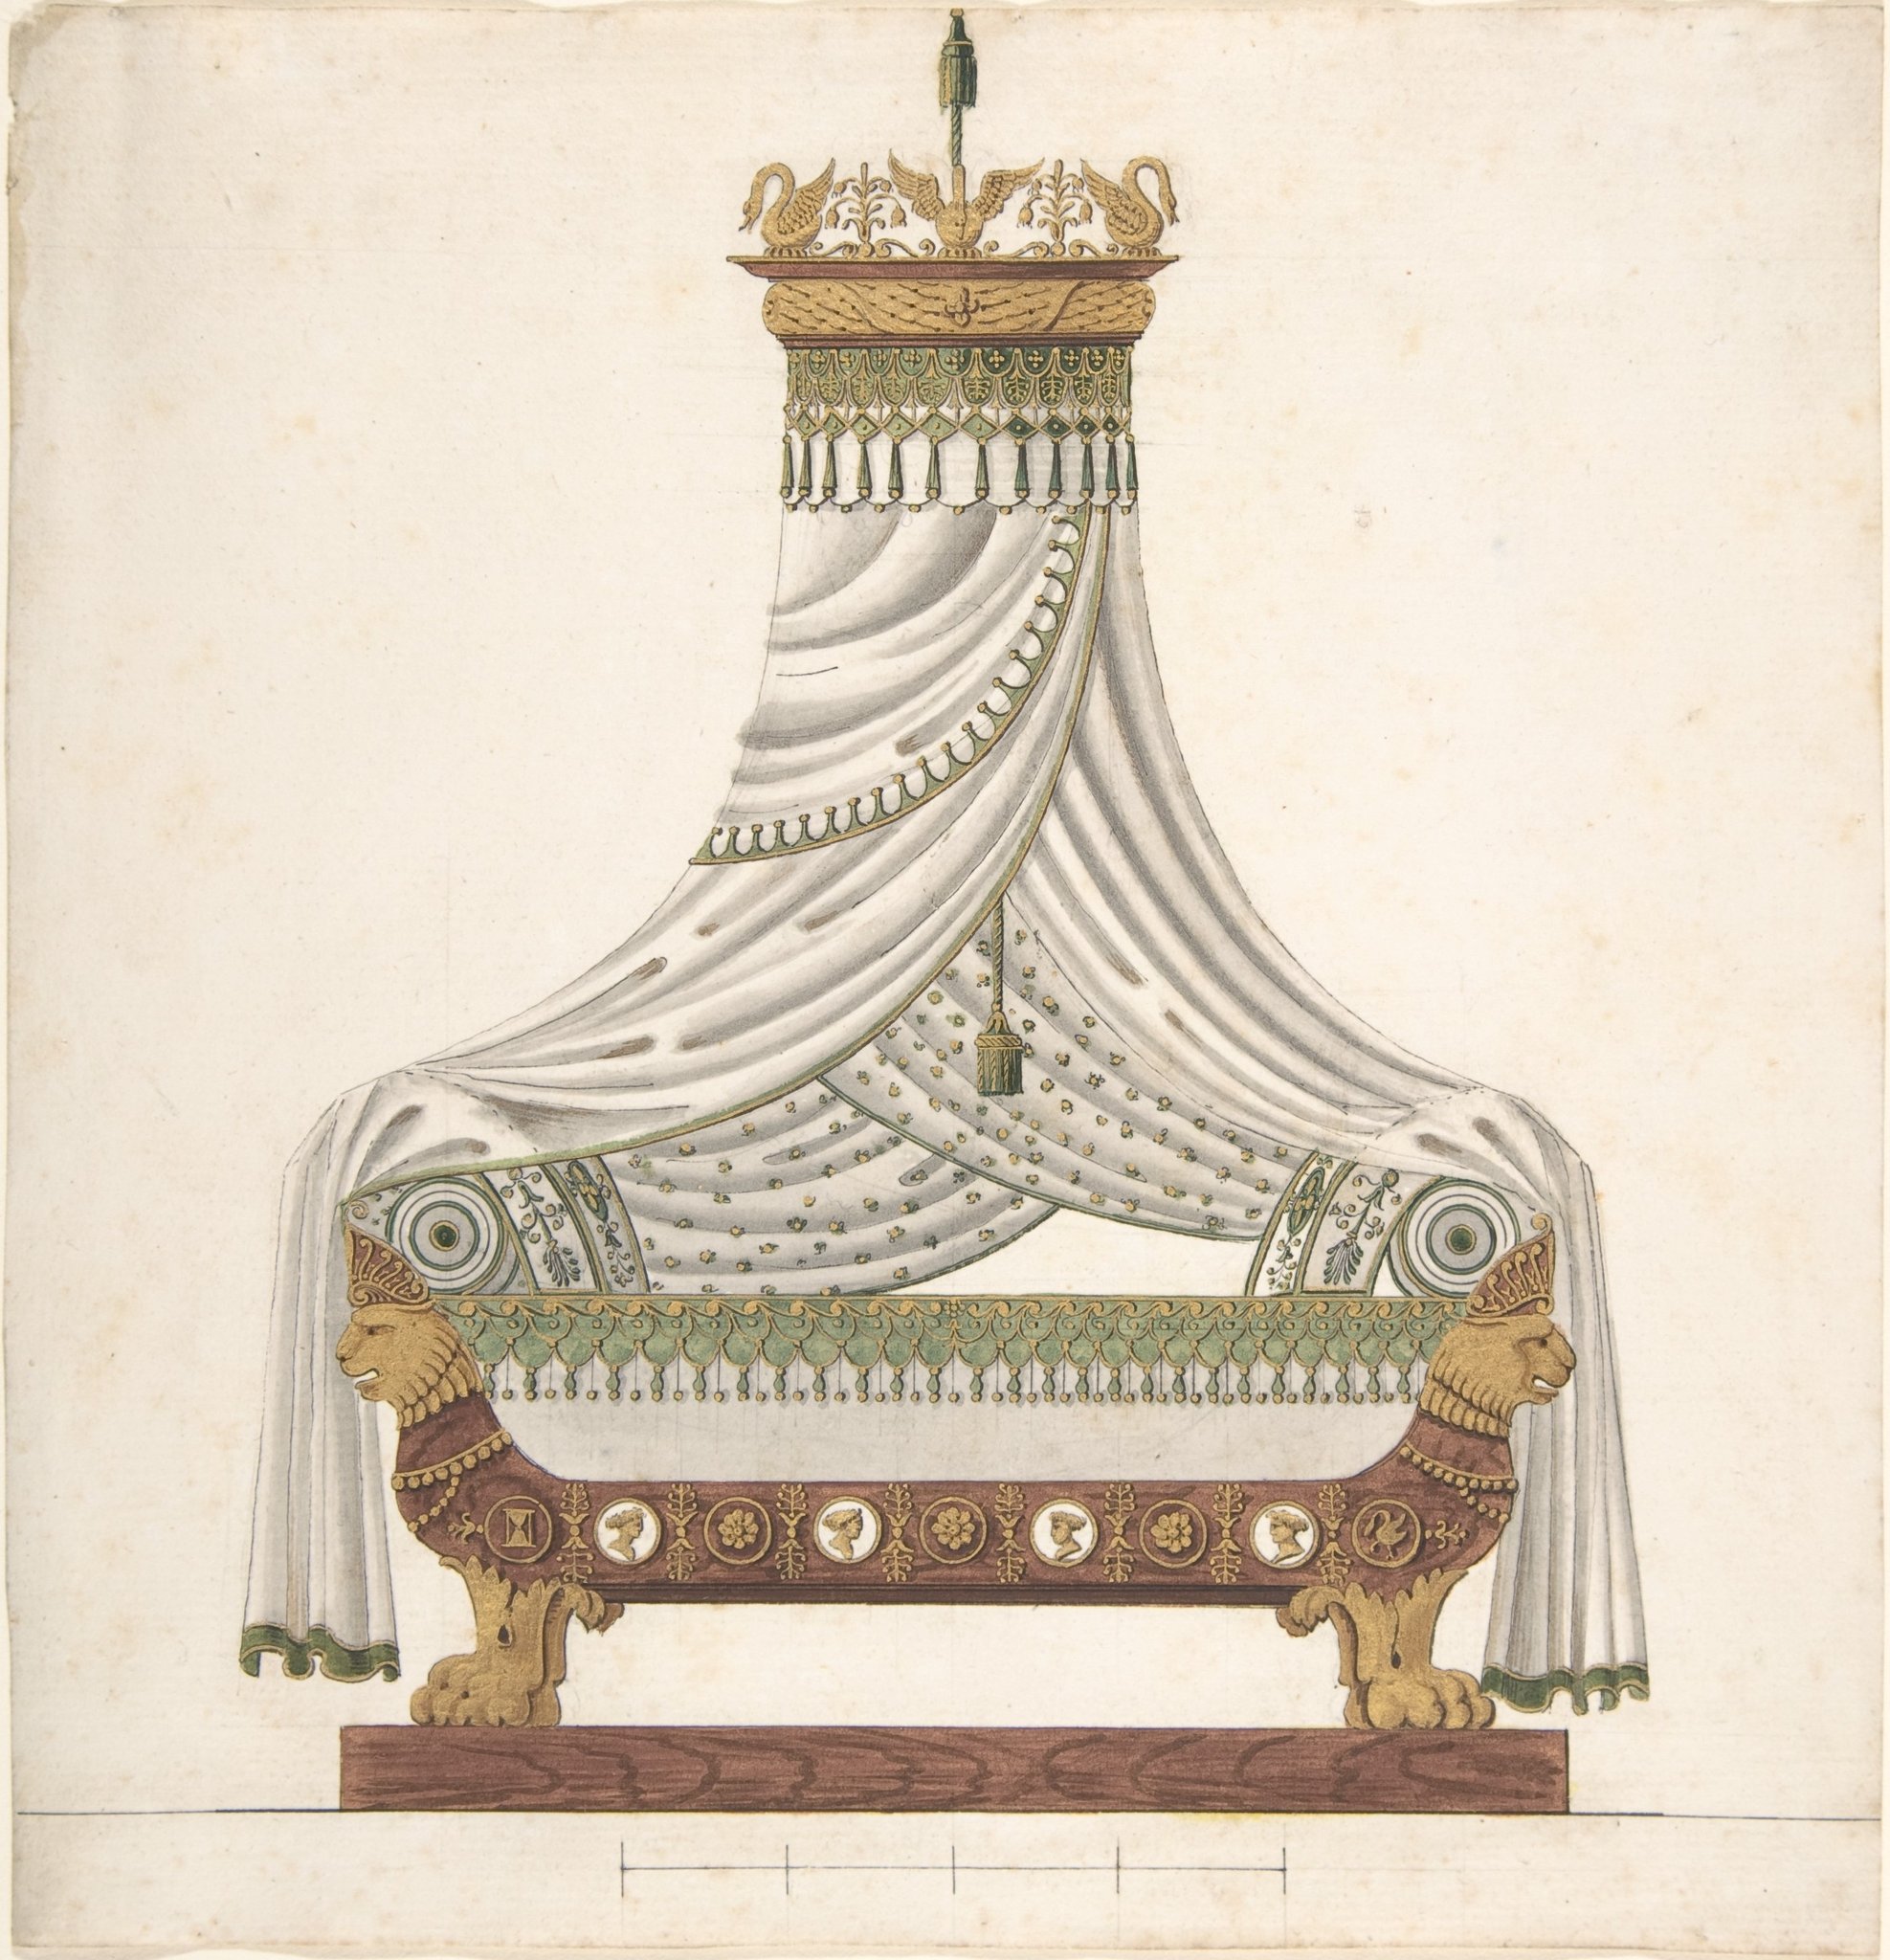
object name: drawing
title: Design for Canopy Bed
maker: anonymous, french, 19th century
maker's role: artist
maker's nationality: french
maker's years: 1800-1900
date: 1801-1900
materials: gold, gouache, ink, paint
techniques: pen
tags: beds